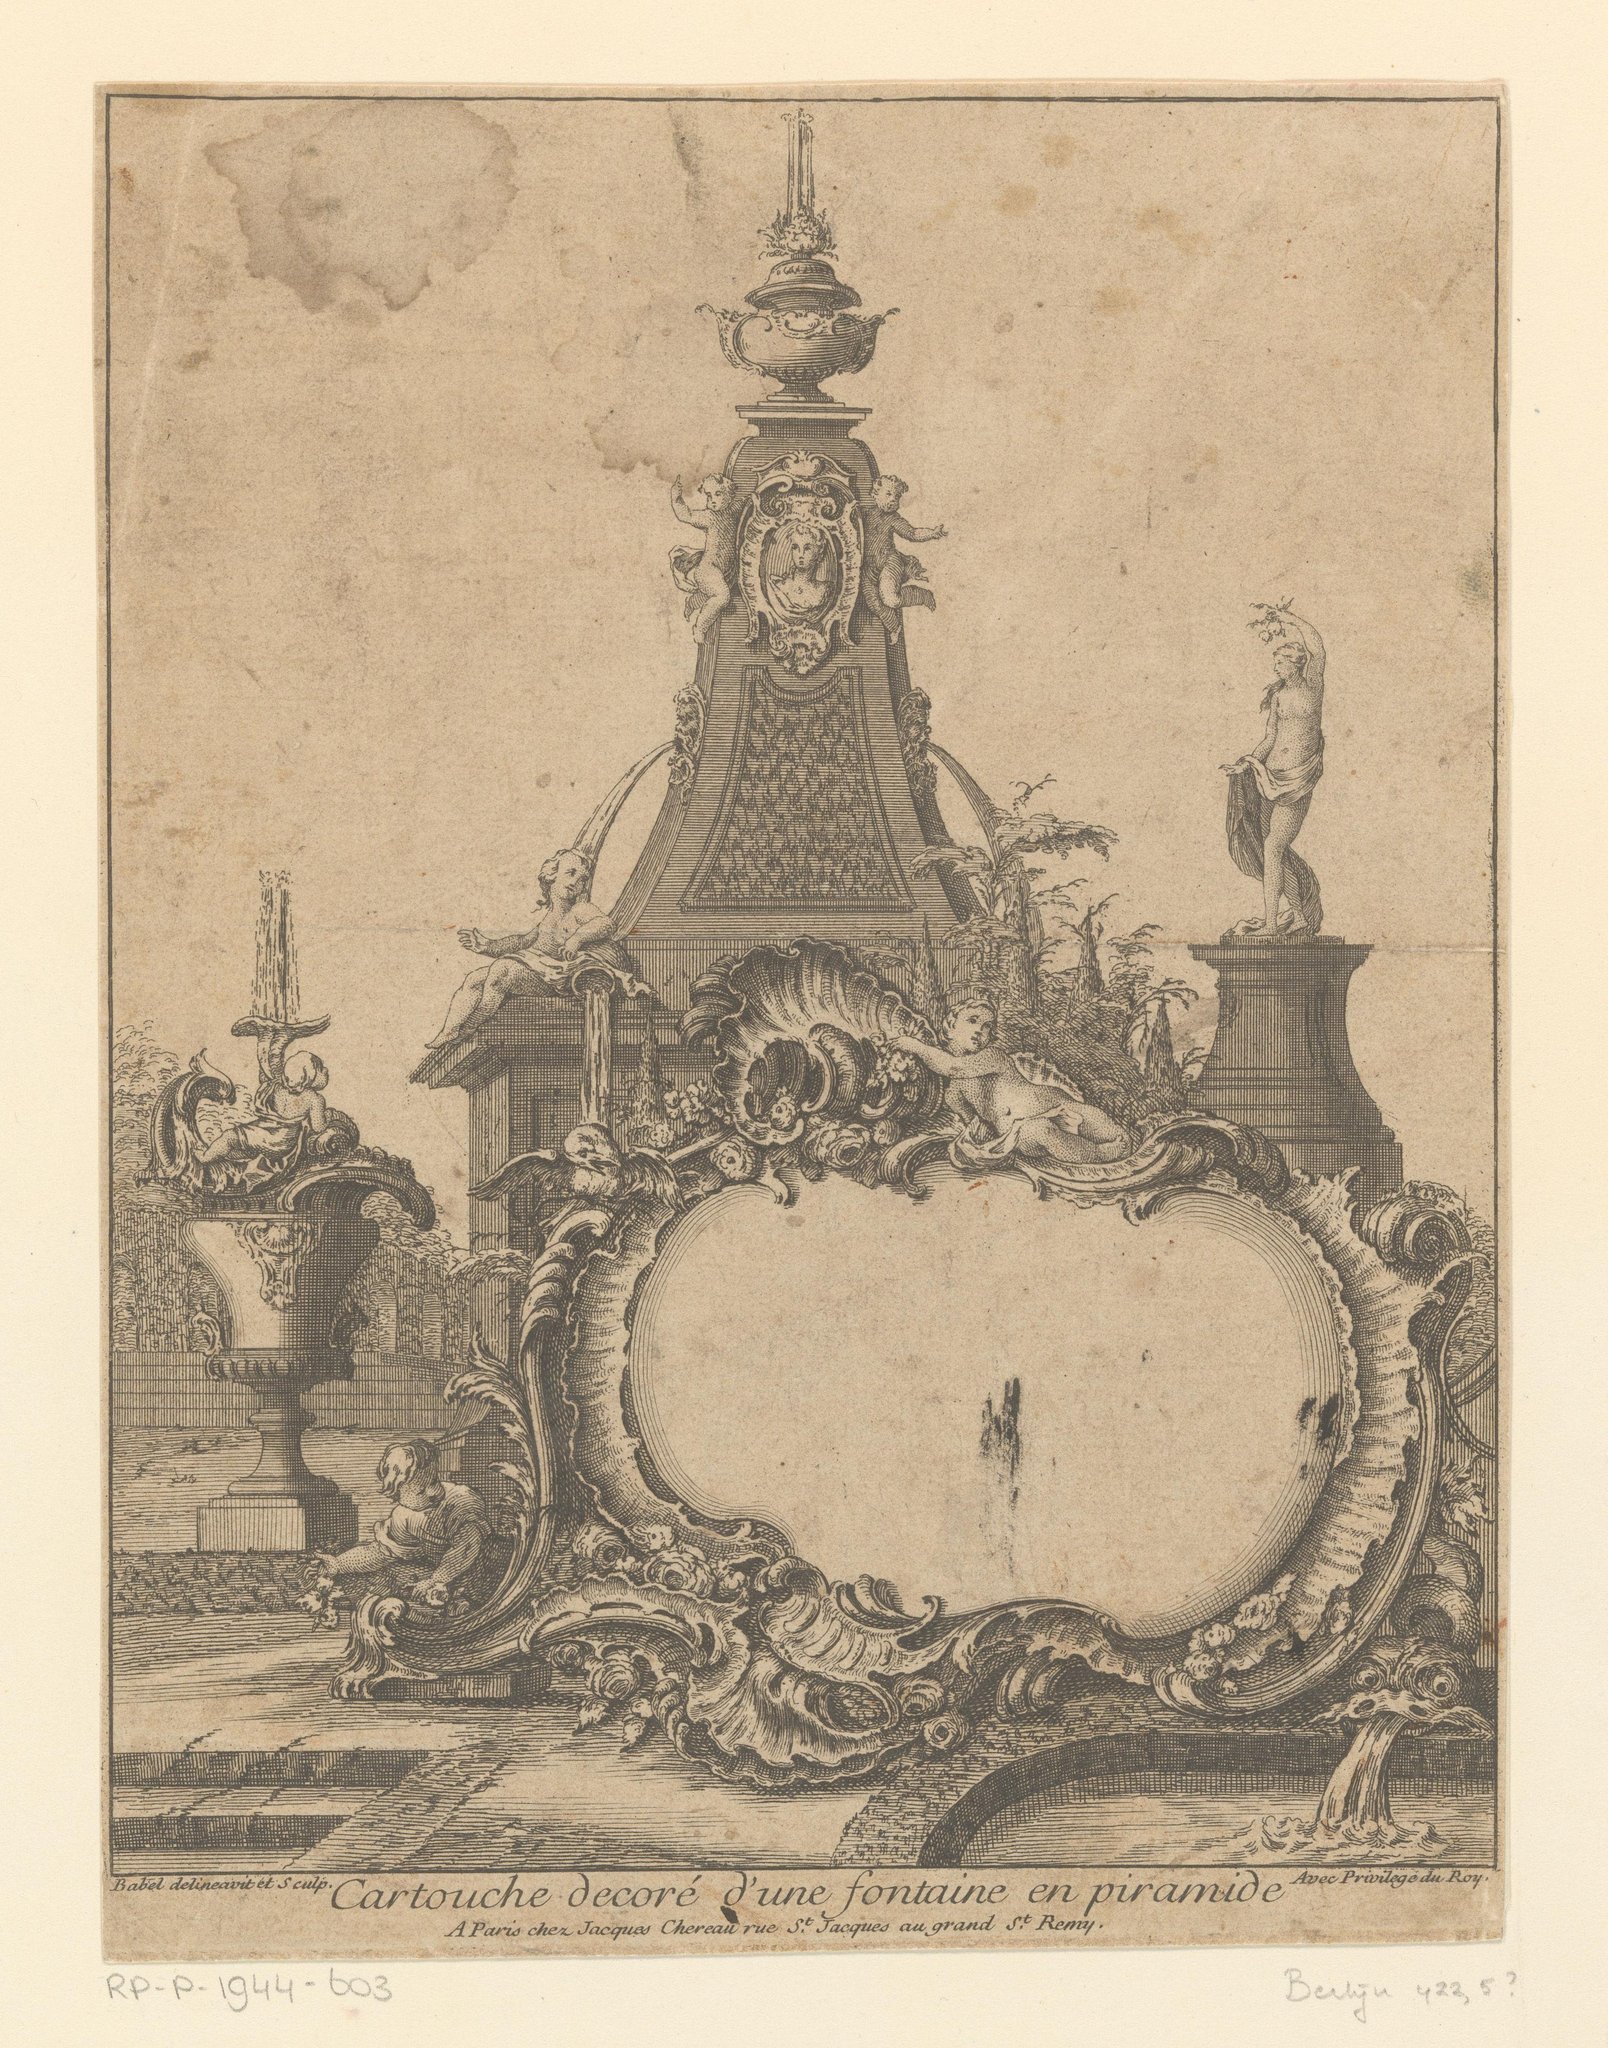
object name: ornament print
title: Cartouche decoré d'une fontaine en piramide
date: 1730-1775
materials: paper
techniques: etching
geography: paris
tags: garden fountain, ornament ~ cartouche, cupids: 'amores', 'amoretti', 'putti'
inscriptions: collector's mark: Lugt 2228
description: Een rocaille cartouche met putti in een tuin met een piramidevormige fontein met putti, cartouche met buste en een vaas. Links een fontein in de vorm van een vaas. Rechts een sculptuur op een sokkel.